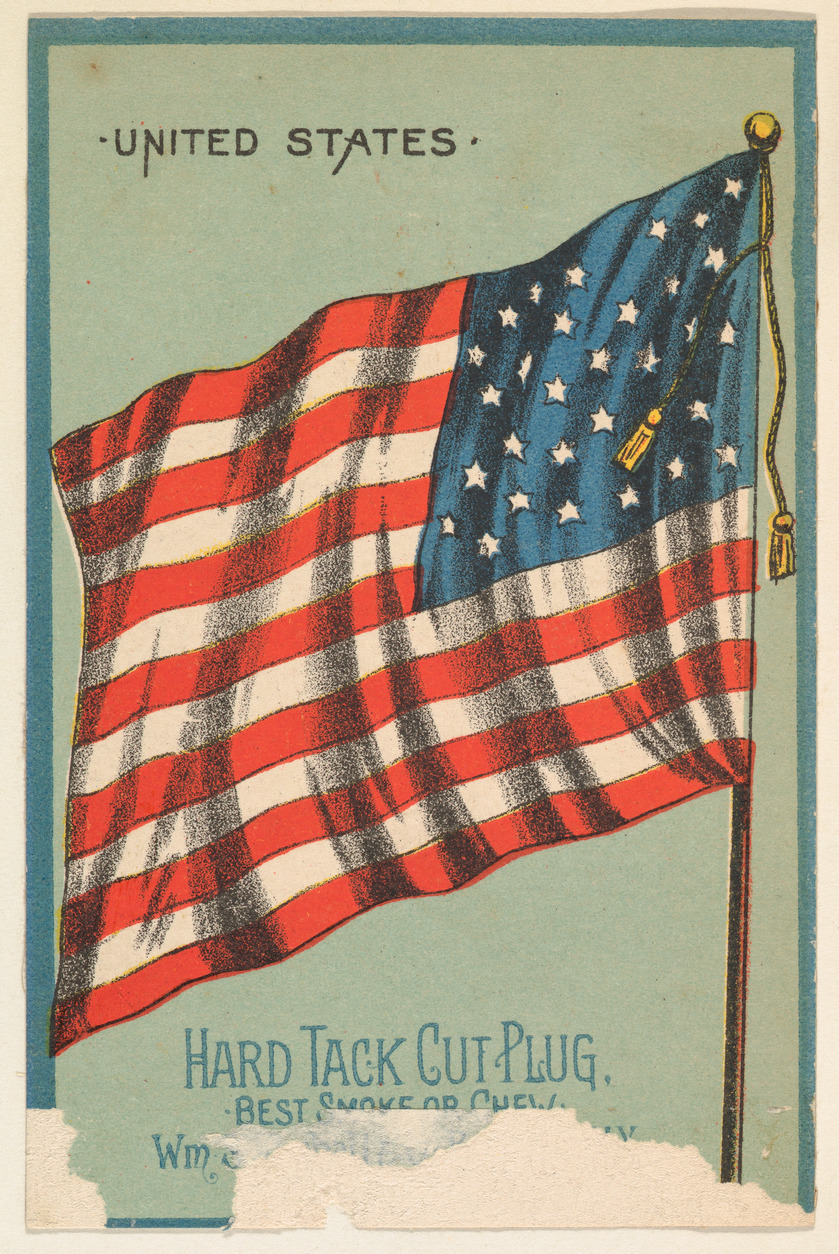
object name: print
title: United States, from the National Flags series (N195) issued by Wm. S. Kimball & Co.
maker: william s. kimball & company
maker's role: publisher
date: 1891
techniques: color lithograph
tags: flags